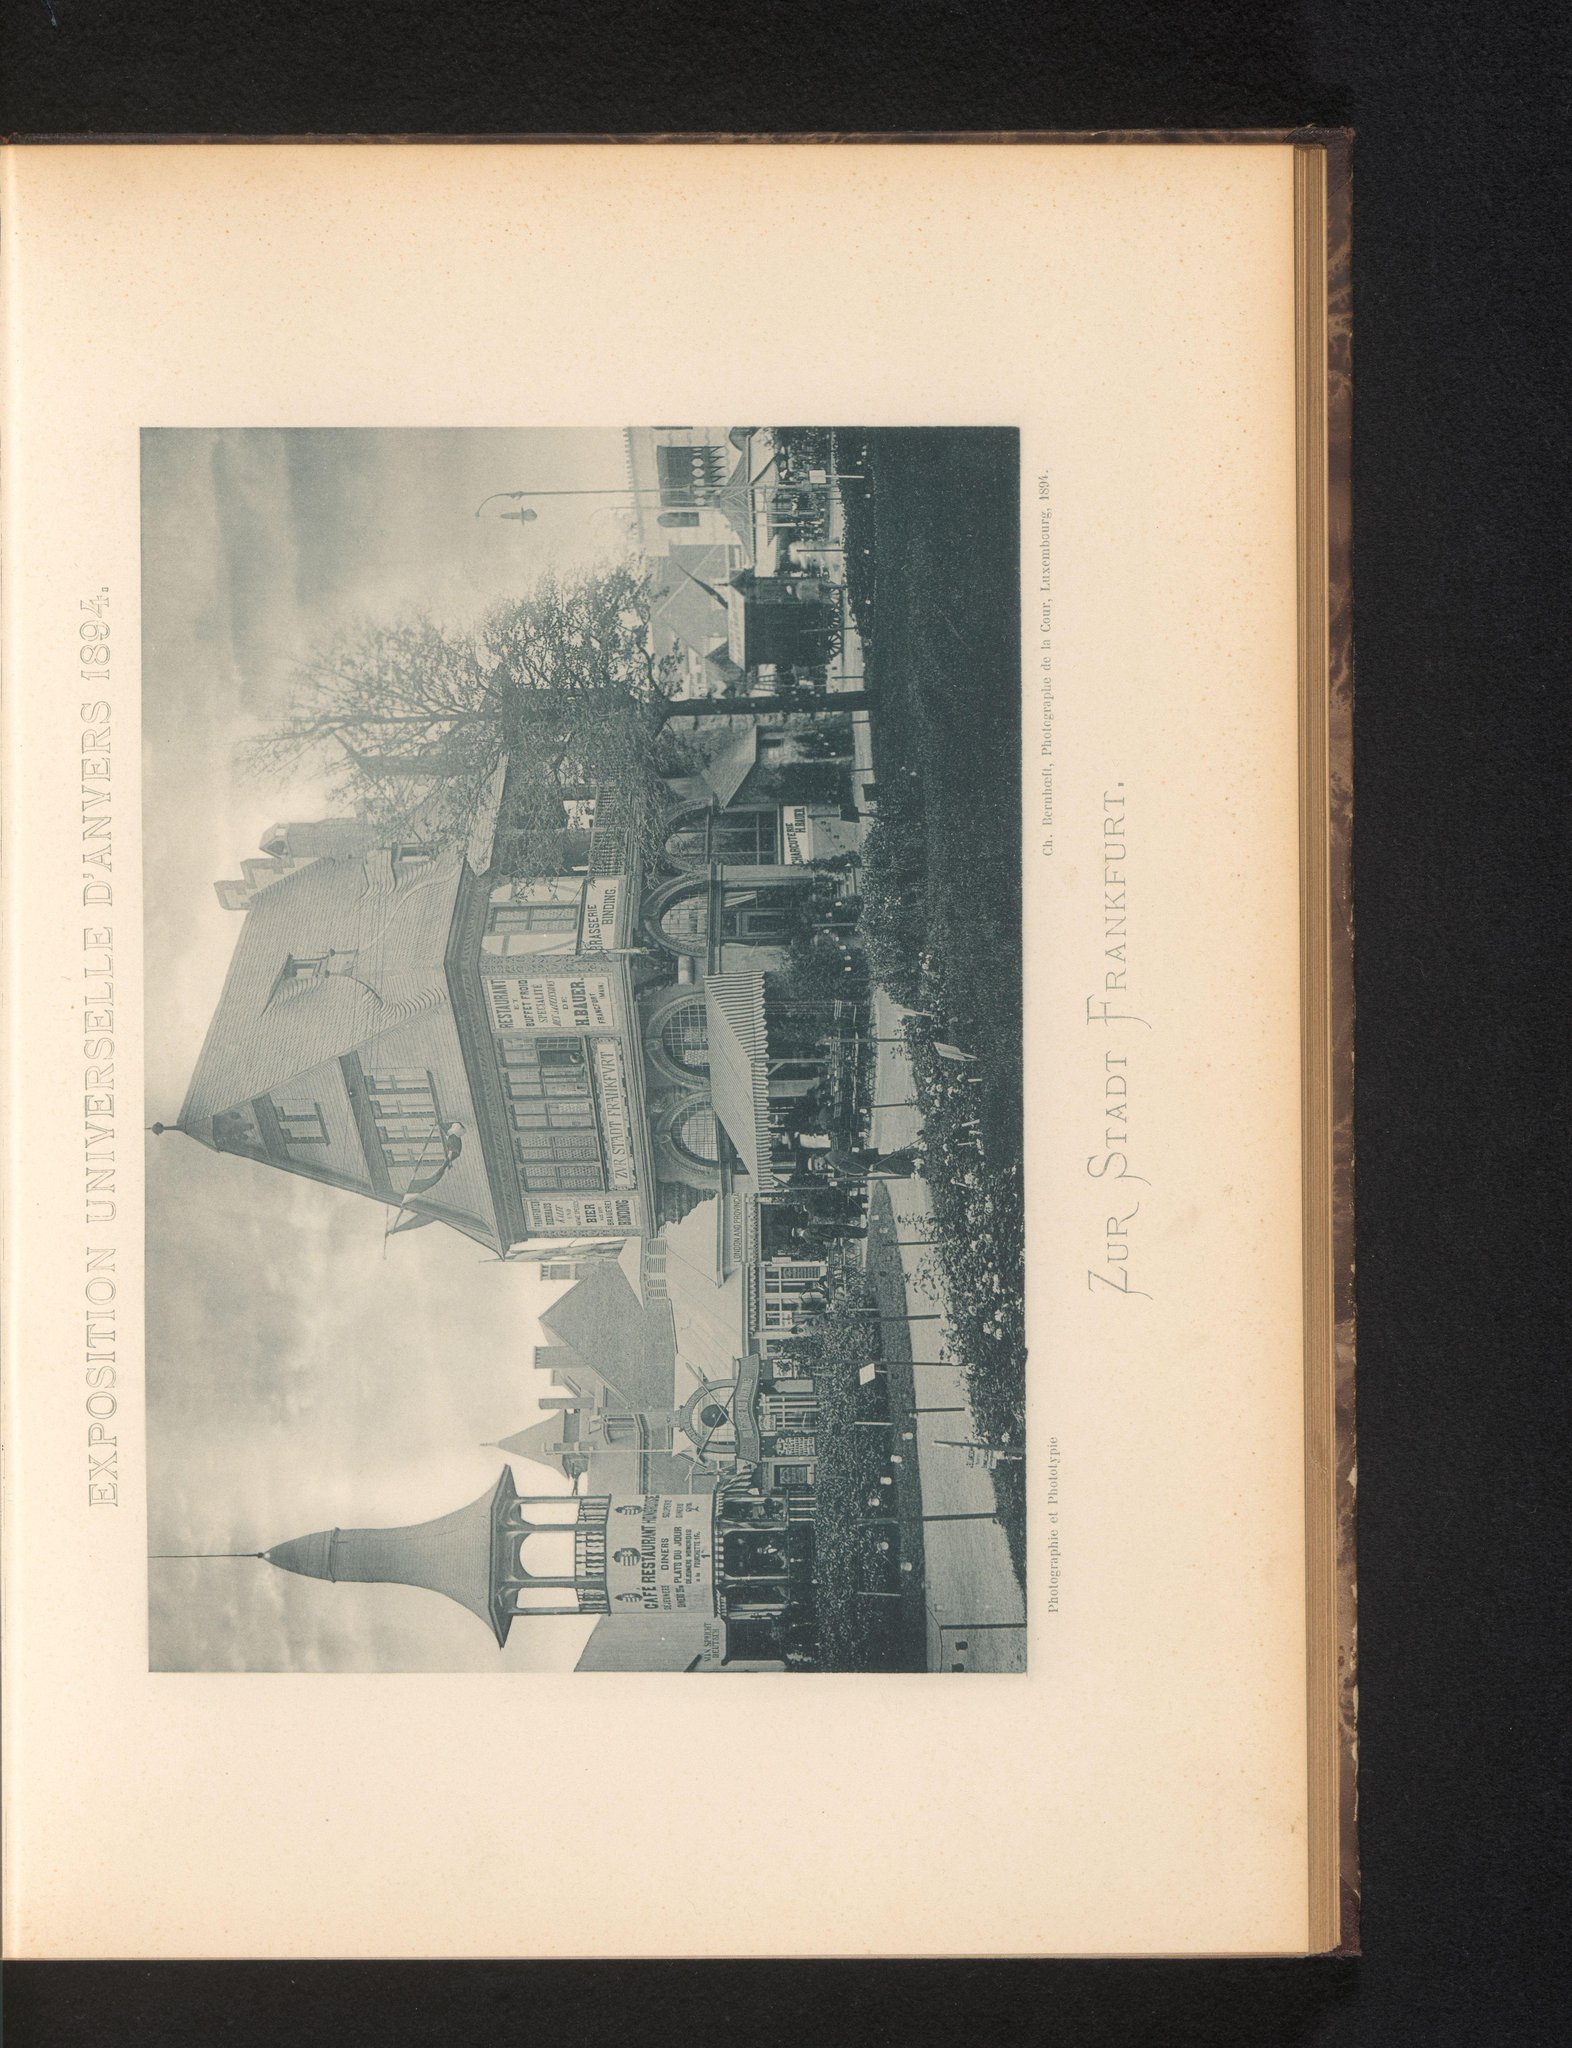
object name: photomechanical print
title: Exposition Universelle d'Anvers 1894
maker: charles bernhoeft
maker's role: publisher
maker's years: 1859-1933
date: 1894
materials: paper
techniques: photograph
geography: antwerp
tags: world fair, world exhibition, restaurant, civic architecture; edifices; dwellings, antwerp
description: Prent op derde ongenummerde pagina na pagina 18.